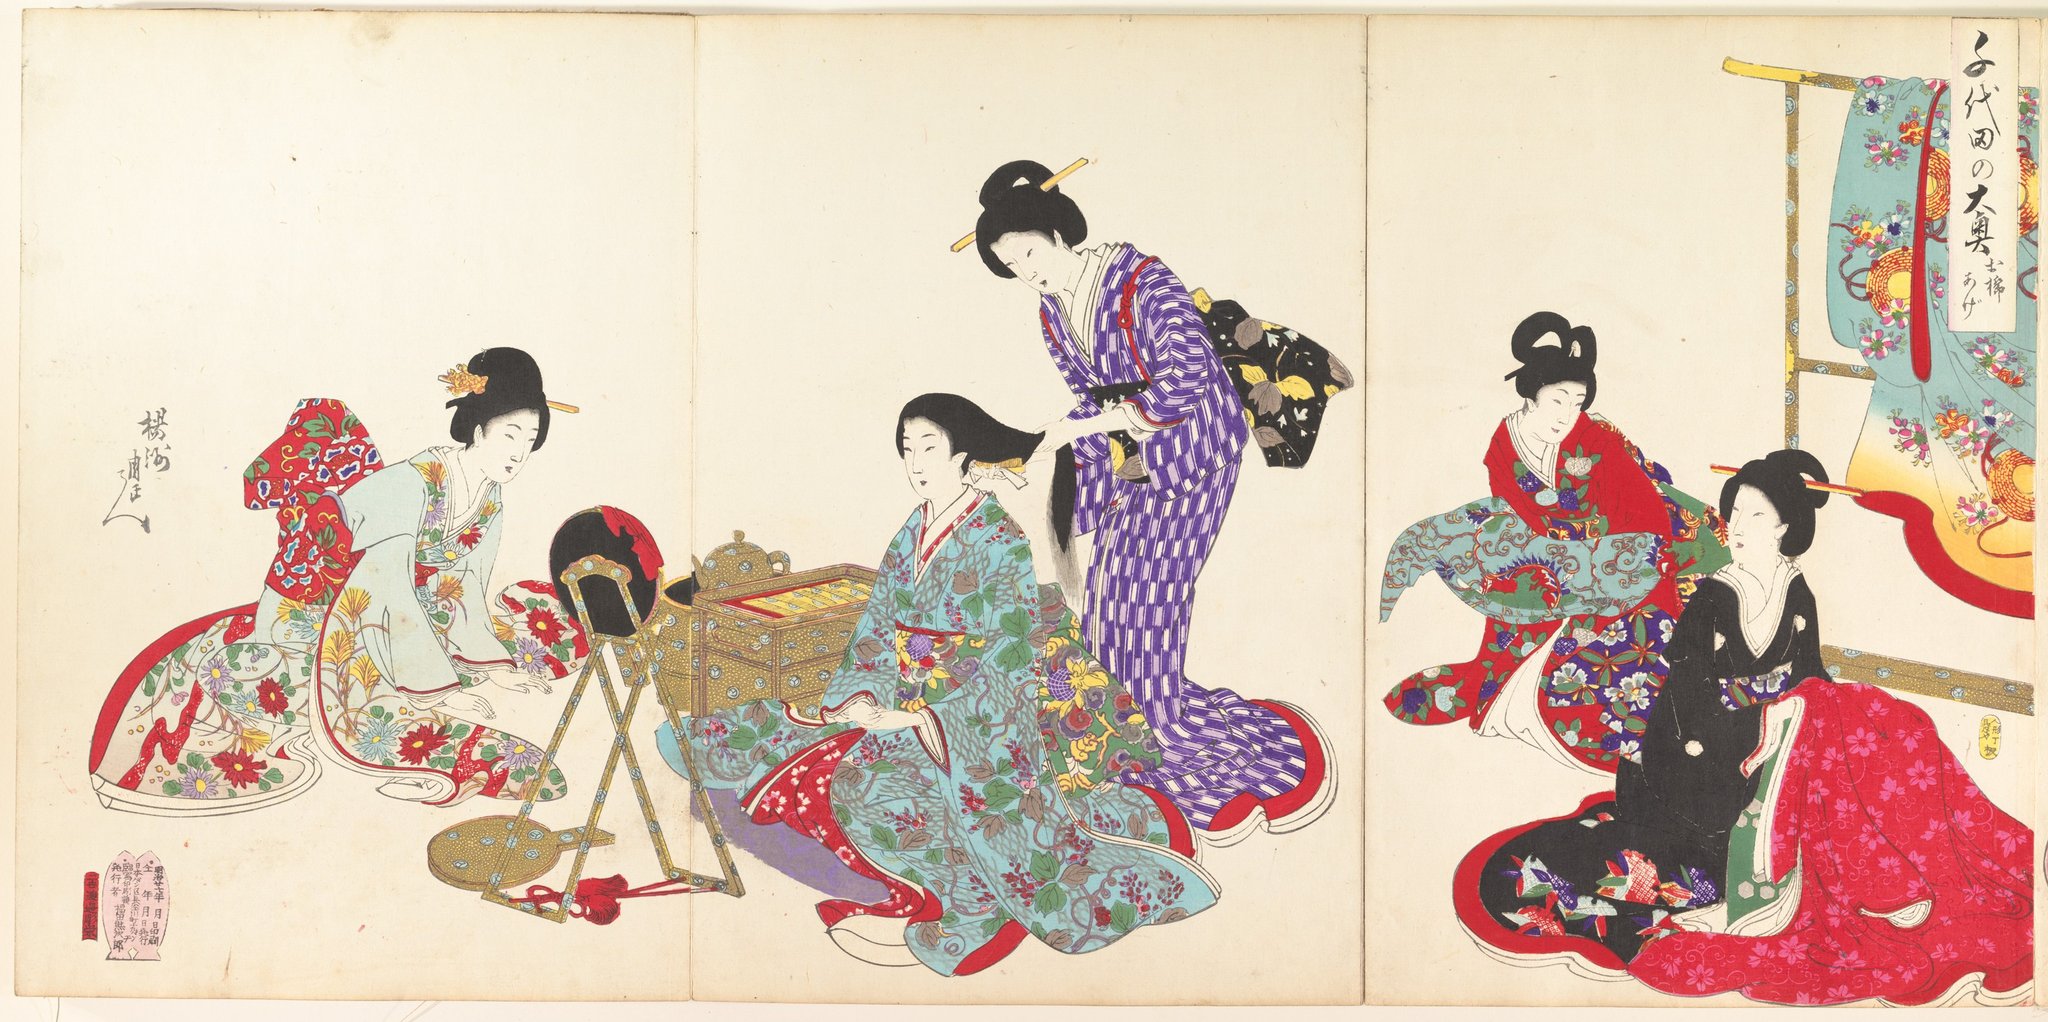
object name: print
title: Chiyoda Castle (Album of Women)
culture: japanese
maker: yōshū (hashimoto) chikanobu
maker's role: artist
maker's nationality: japanese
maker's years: 1838-1912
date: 1895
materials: ink, paper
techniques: woodblock print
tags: women